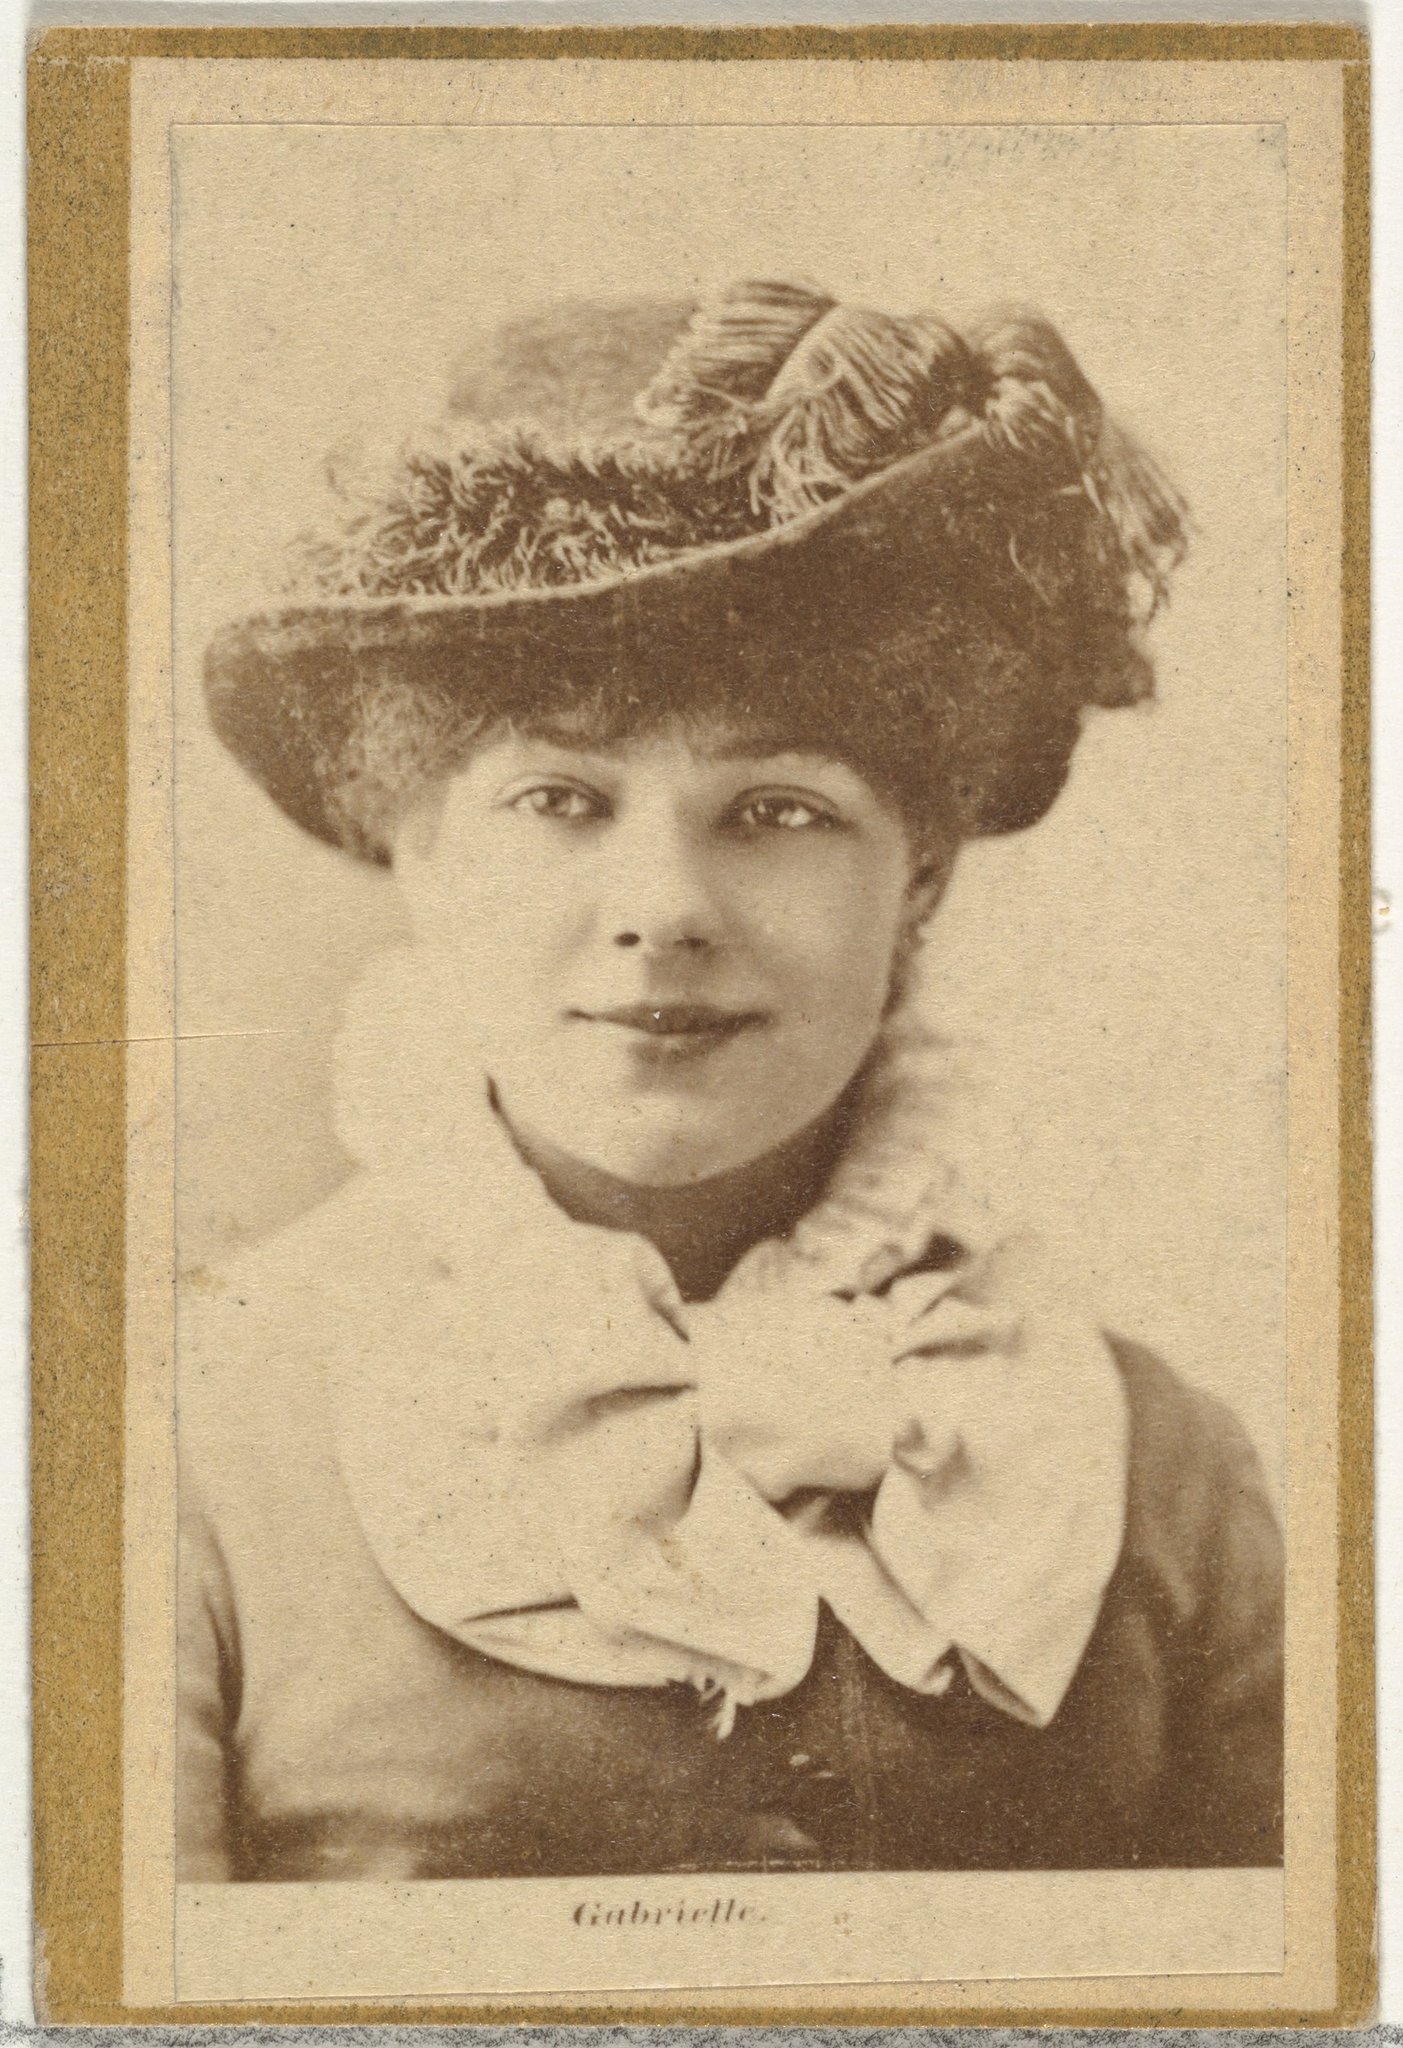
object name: photograph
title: Gabrielle, from the Actresses and Celebrities series (N60, Type 2) promoting Little Beauties Cigarettes for Allen & Ginter brand tobacco products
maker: allen & ginter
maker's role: publisher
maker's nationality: american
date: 1887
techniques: albumen silver print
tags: portraits,women,actresses